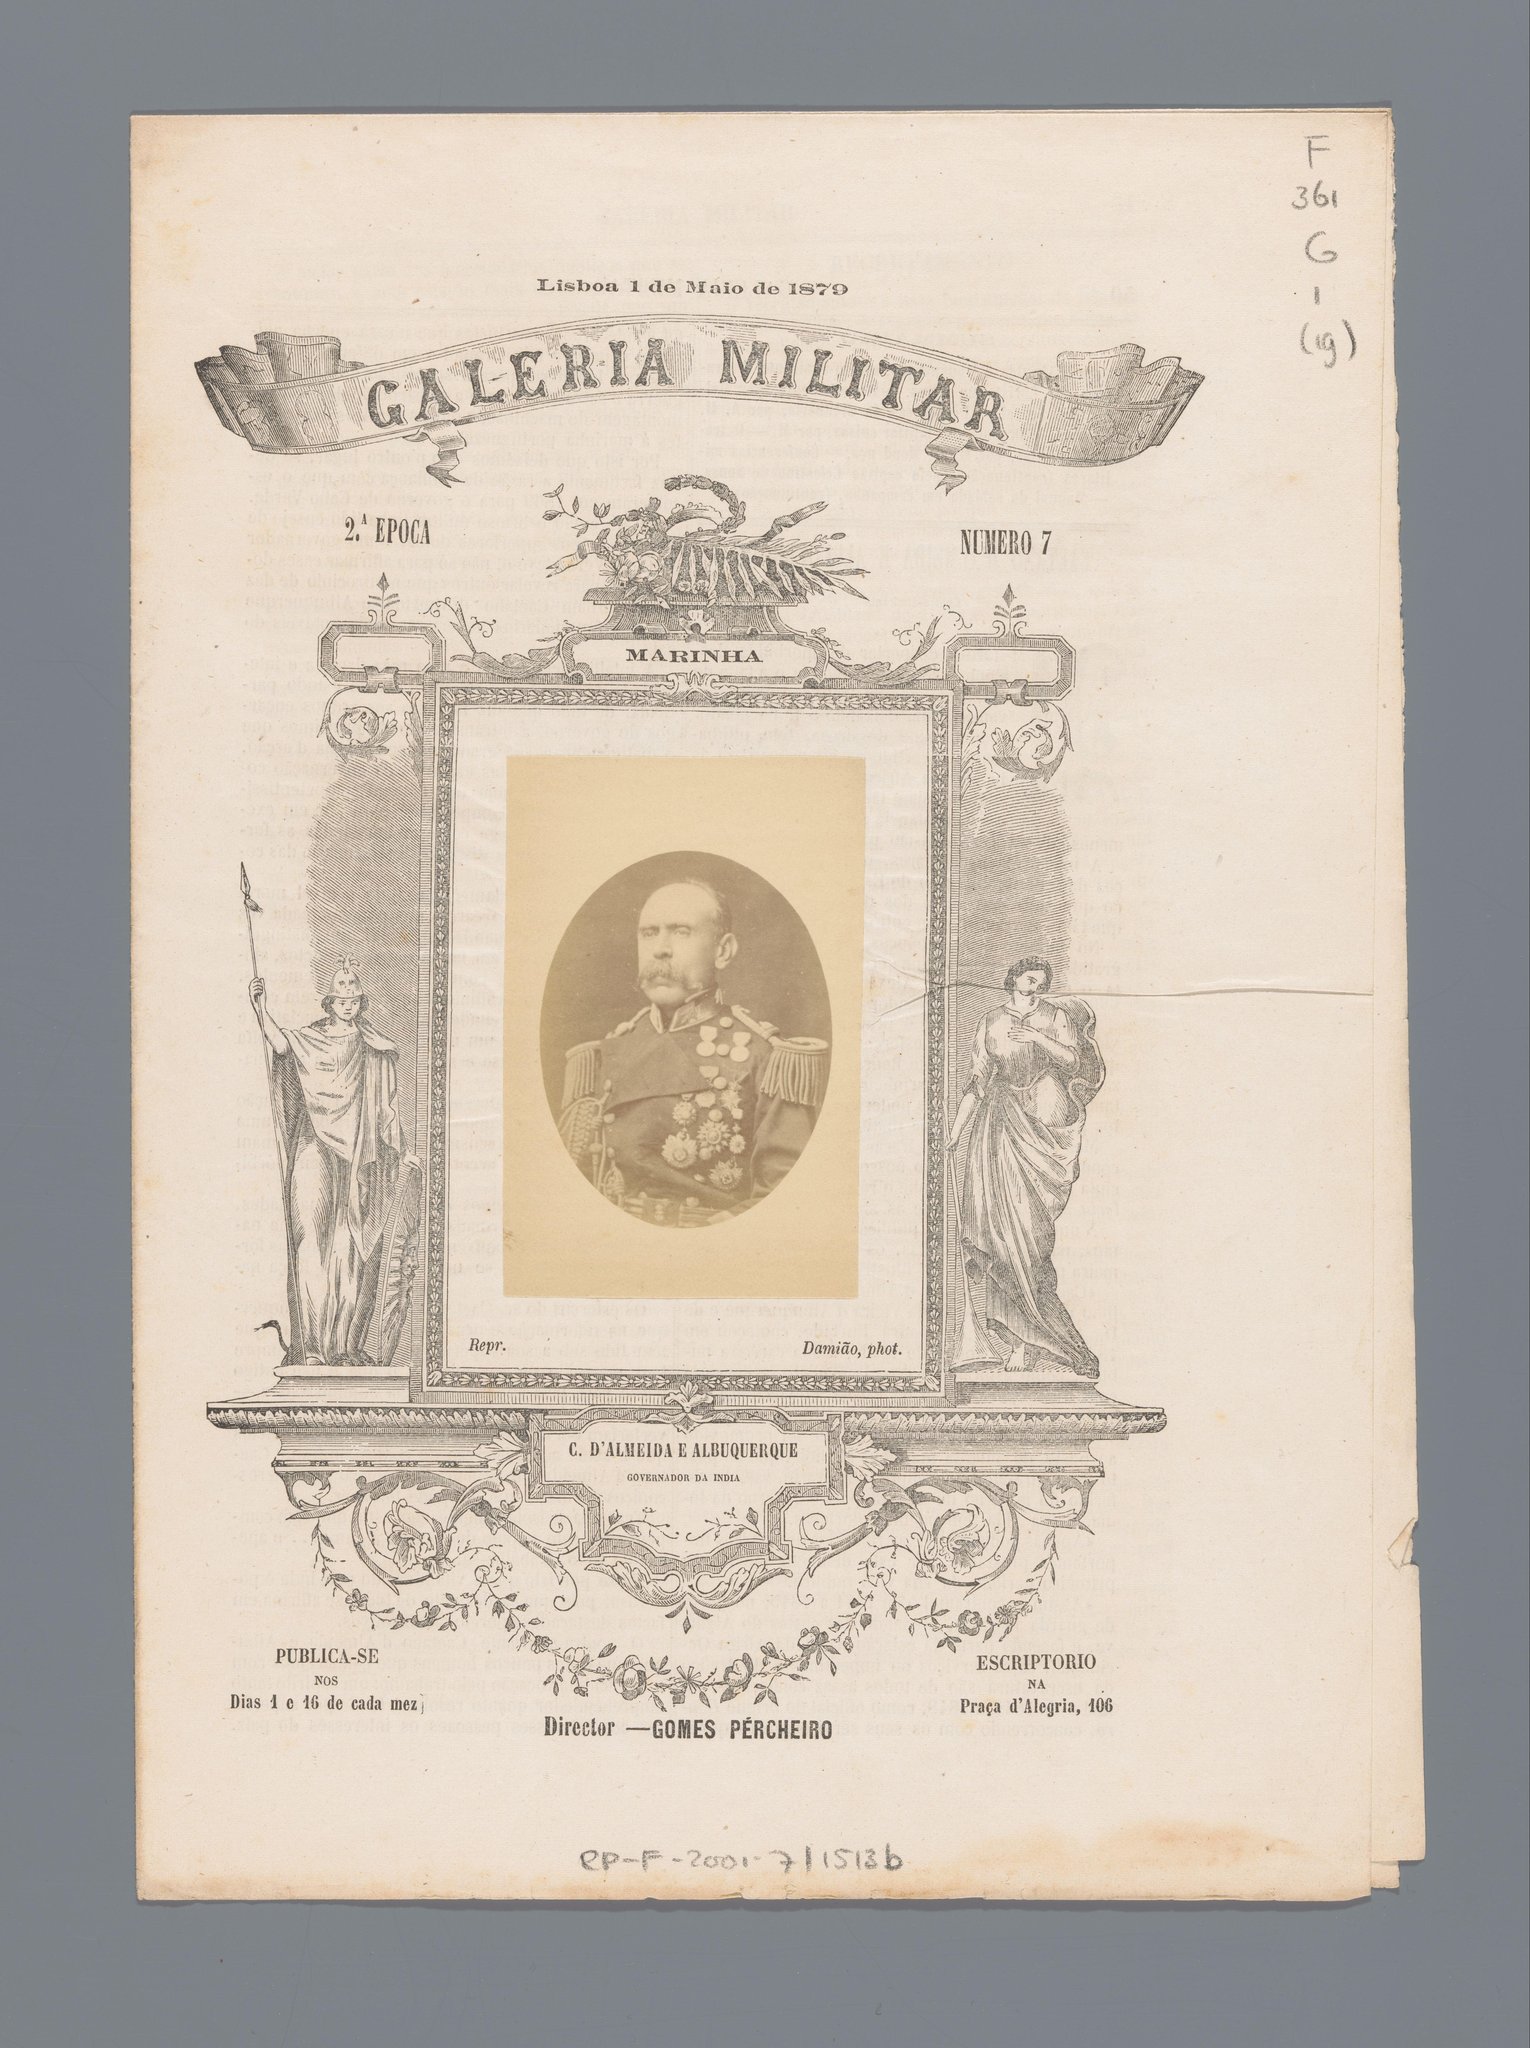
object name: photograph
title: Portret van Caetano Alexandre de Almeida e Albuquerque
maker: damião da graça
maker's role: fotograaf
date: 1874-1879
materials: photographic support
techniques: albumen print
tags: historical persons, commander-in-chief, admiral